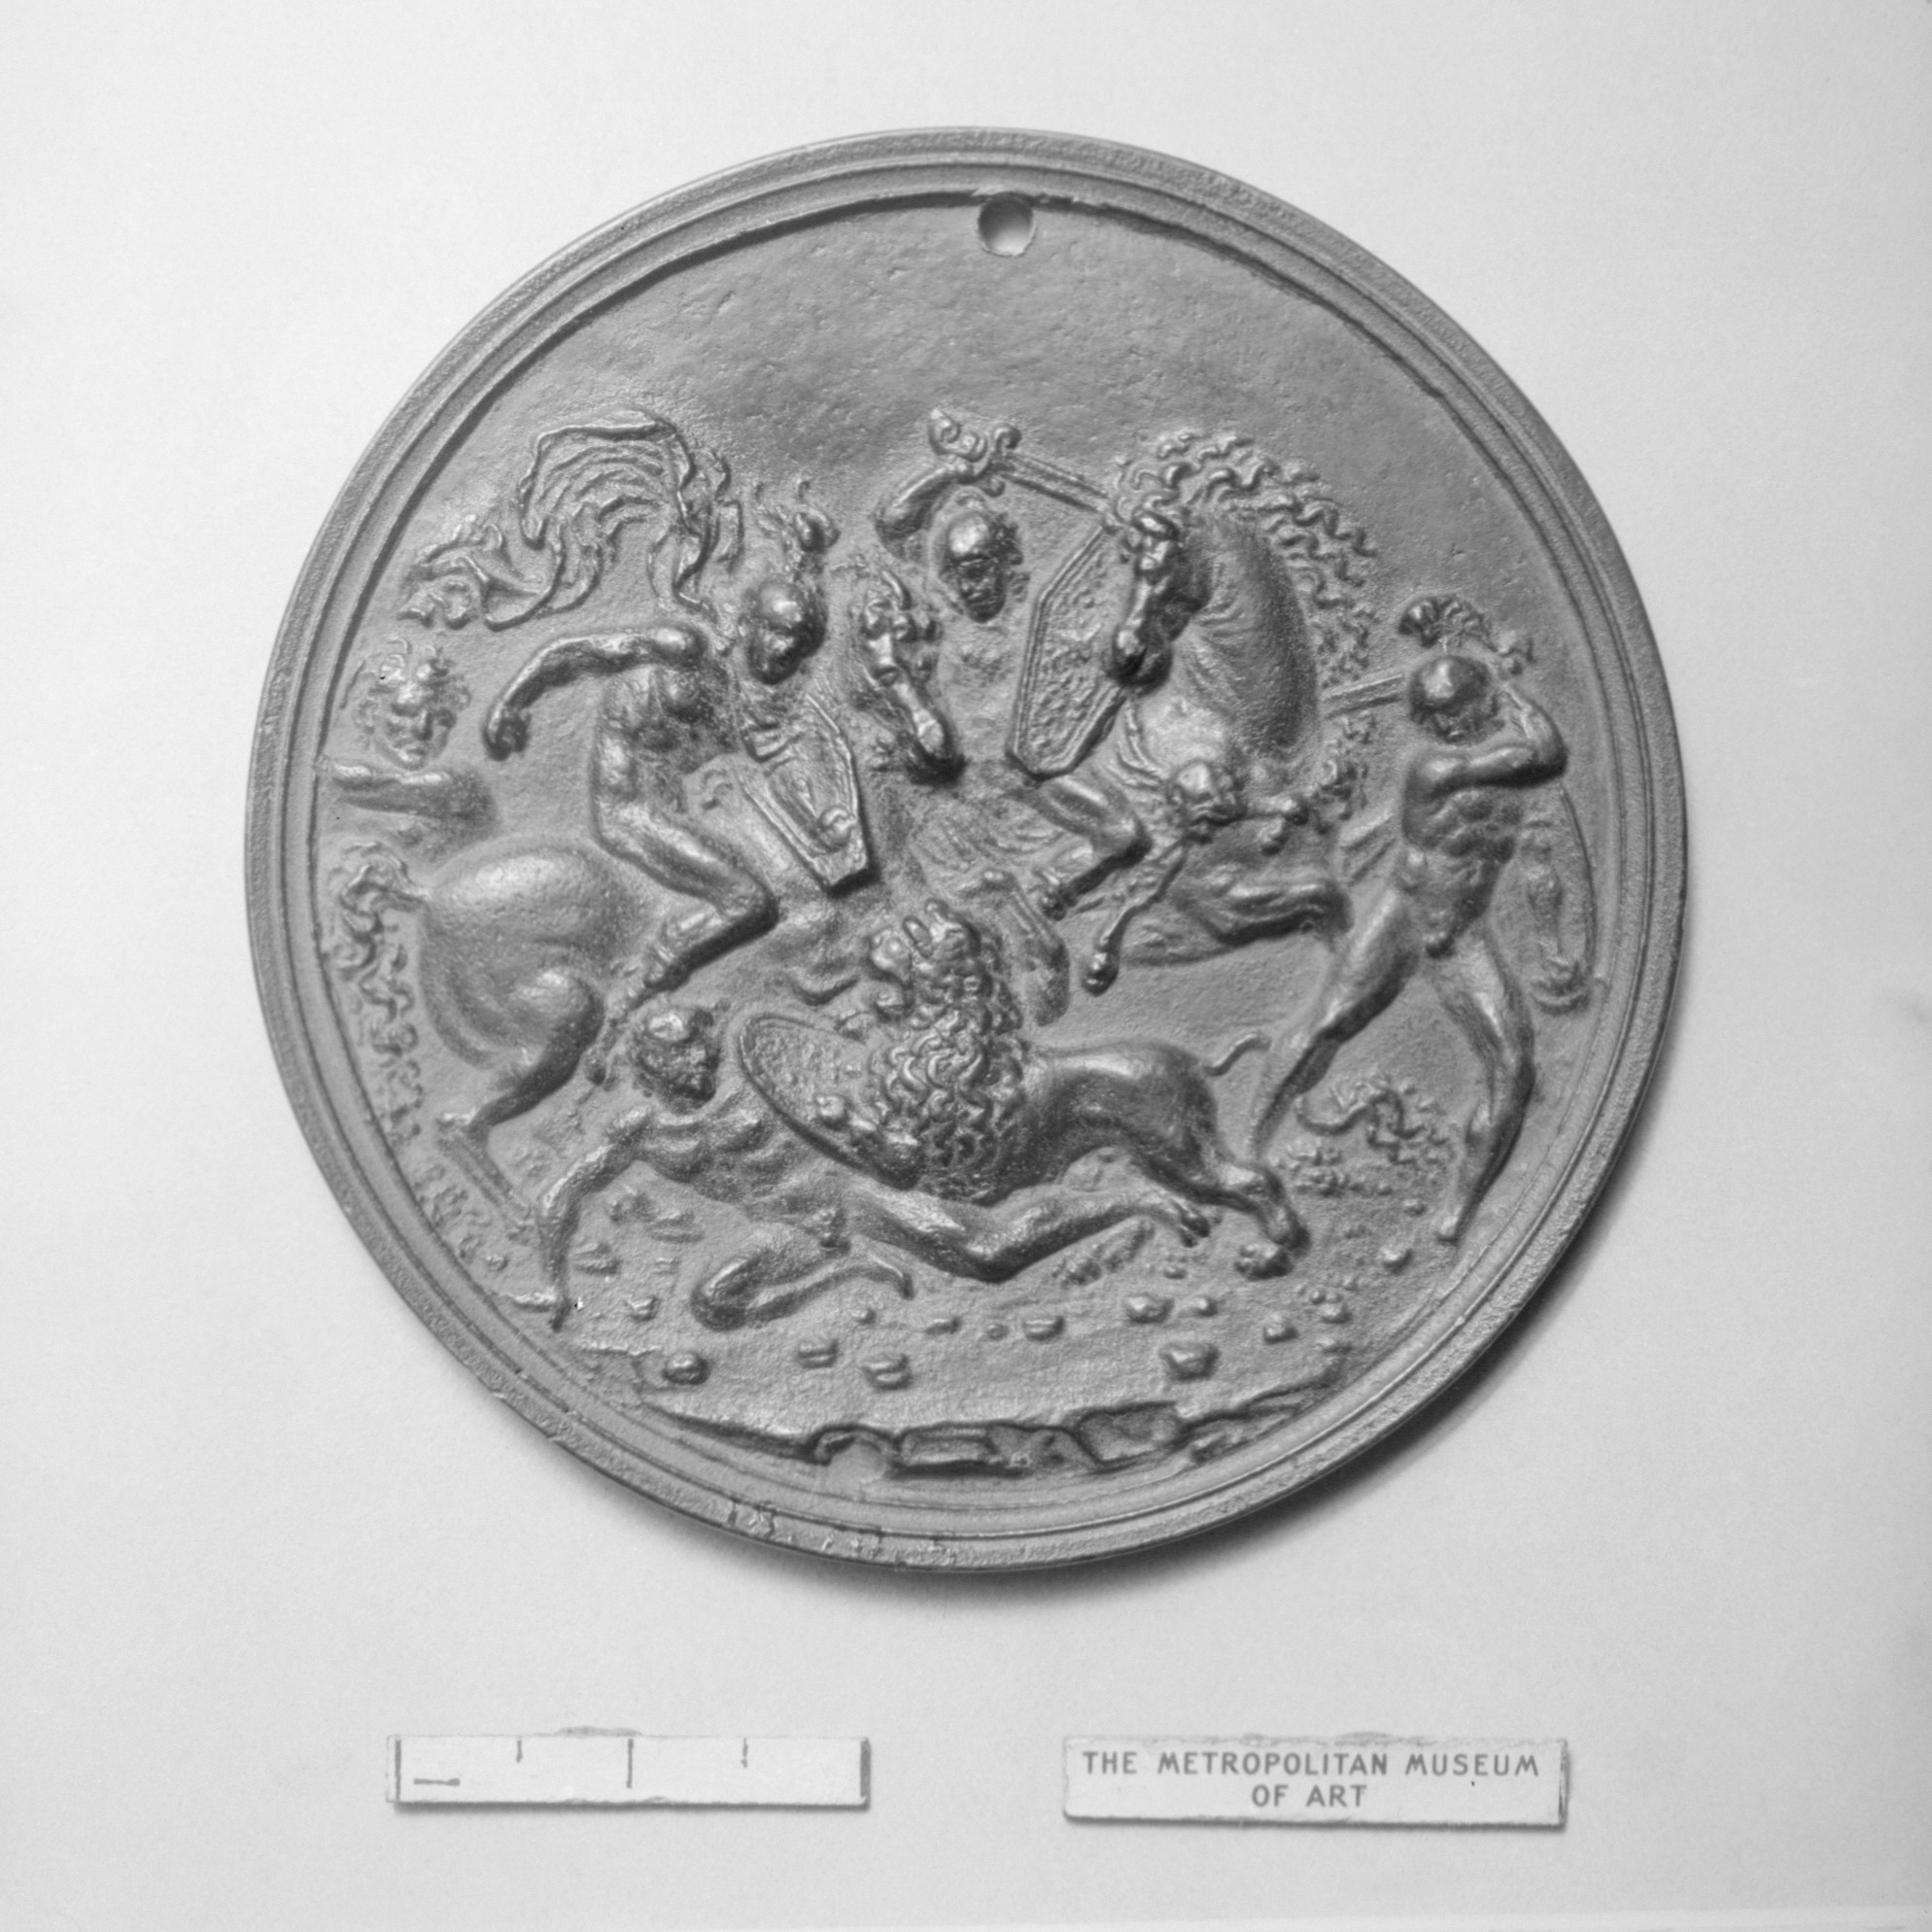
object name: plaquette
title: Lion Hunt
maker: moderno (galeazzo mondella)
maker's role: artist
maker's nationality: italian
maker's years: 1467-1528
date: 1501-1600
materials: bronze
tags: men,male nudes,hunting,horses,lions